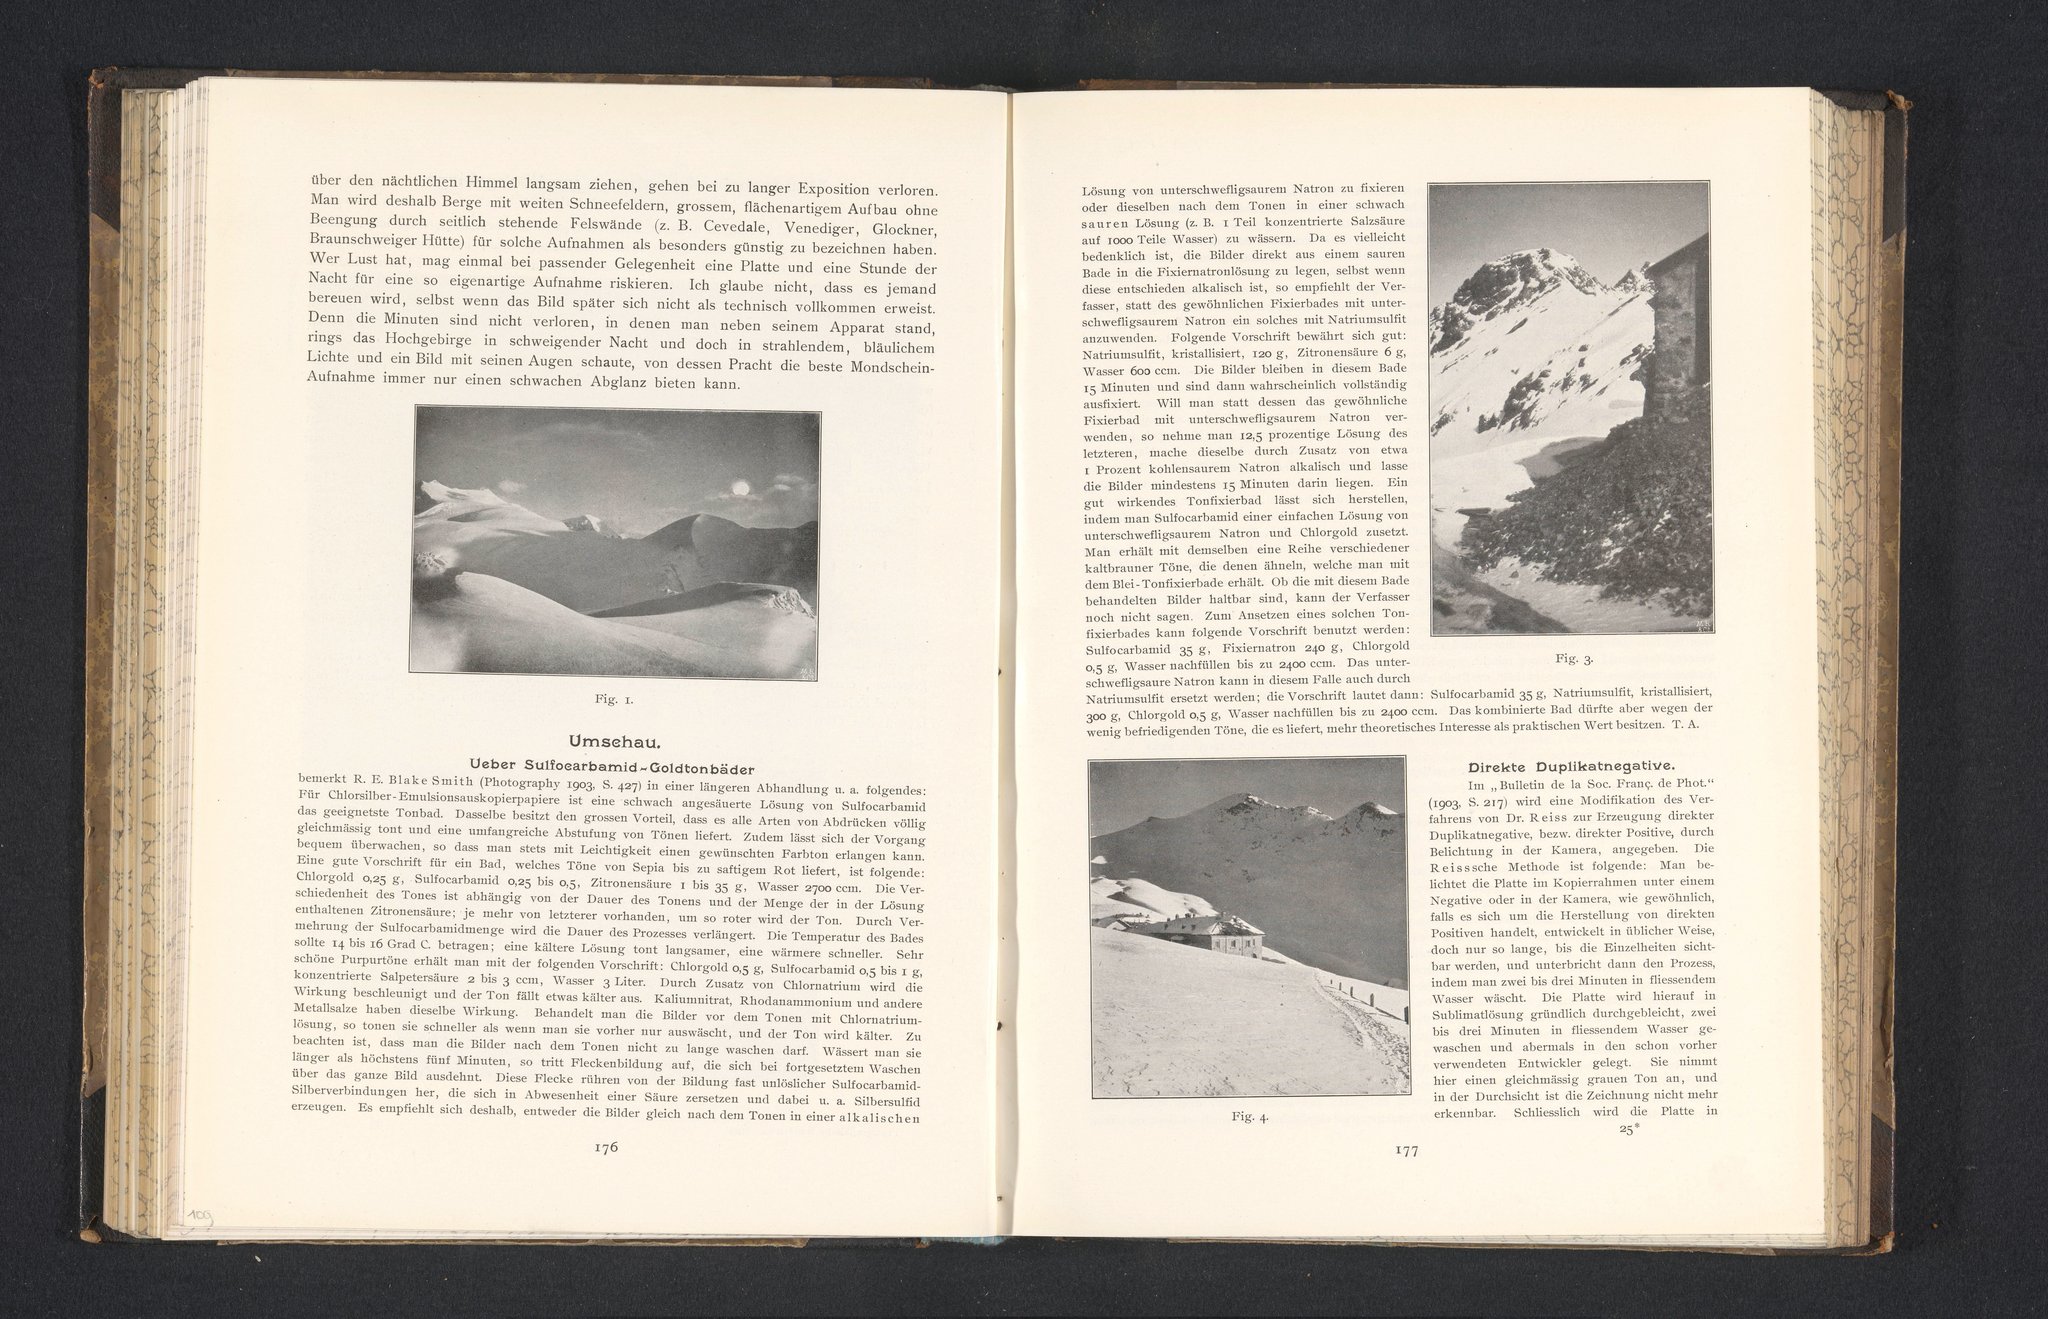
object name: page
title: Winters berglandschap, met op de voorgrond een huis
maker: Anonymous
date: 1898-1903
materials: paper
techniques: autotype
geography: berlin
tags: rural housing, e.g. country-house, villa, cottage, snow, mountains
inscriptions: inscription: ‘Fig. 3’